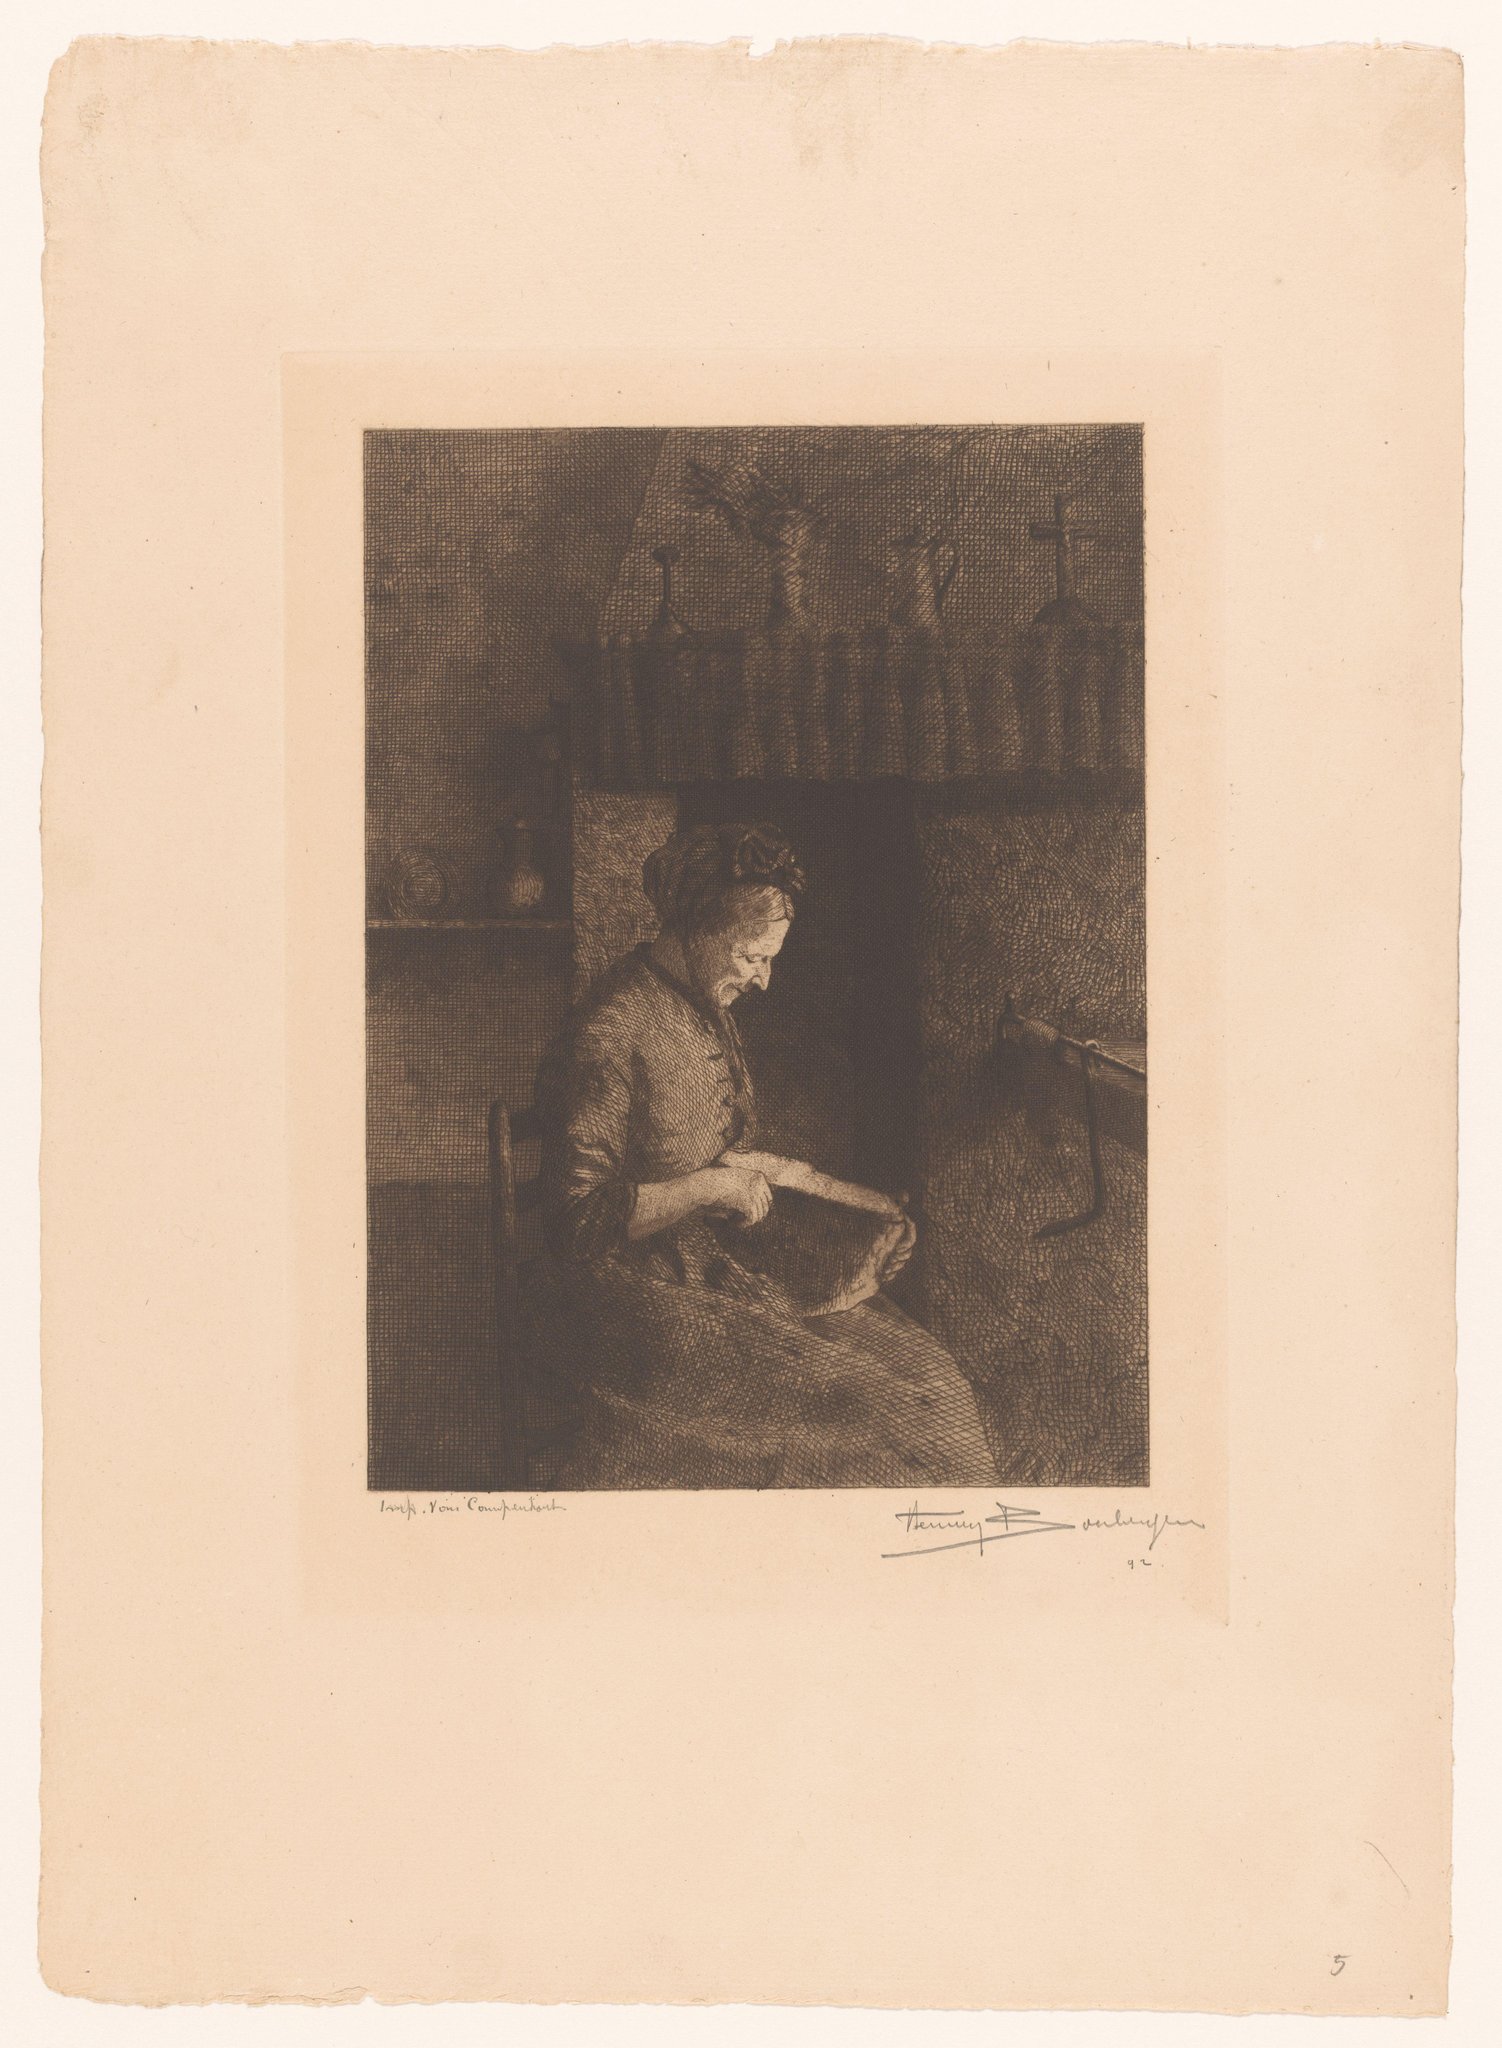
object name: print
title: Oude vrouw snijdt een plak brood af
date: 1892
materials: paper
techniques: drypoint, etching, intaglio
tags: old woman, slicing bread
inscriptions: annotation: ‘Imp. Van Campenhout’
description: Sterfdatum kunstenaar onbekend. Derhalve is voor bepaling van de rechten van dit object de verwervingsdatum aangehouden.